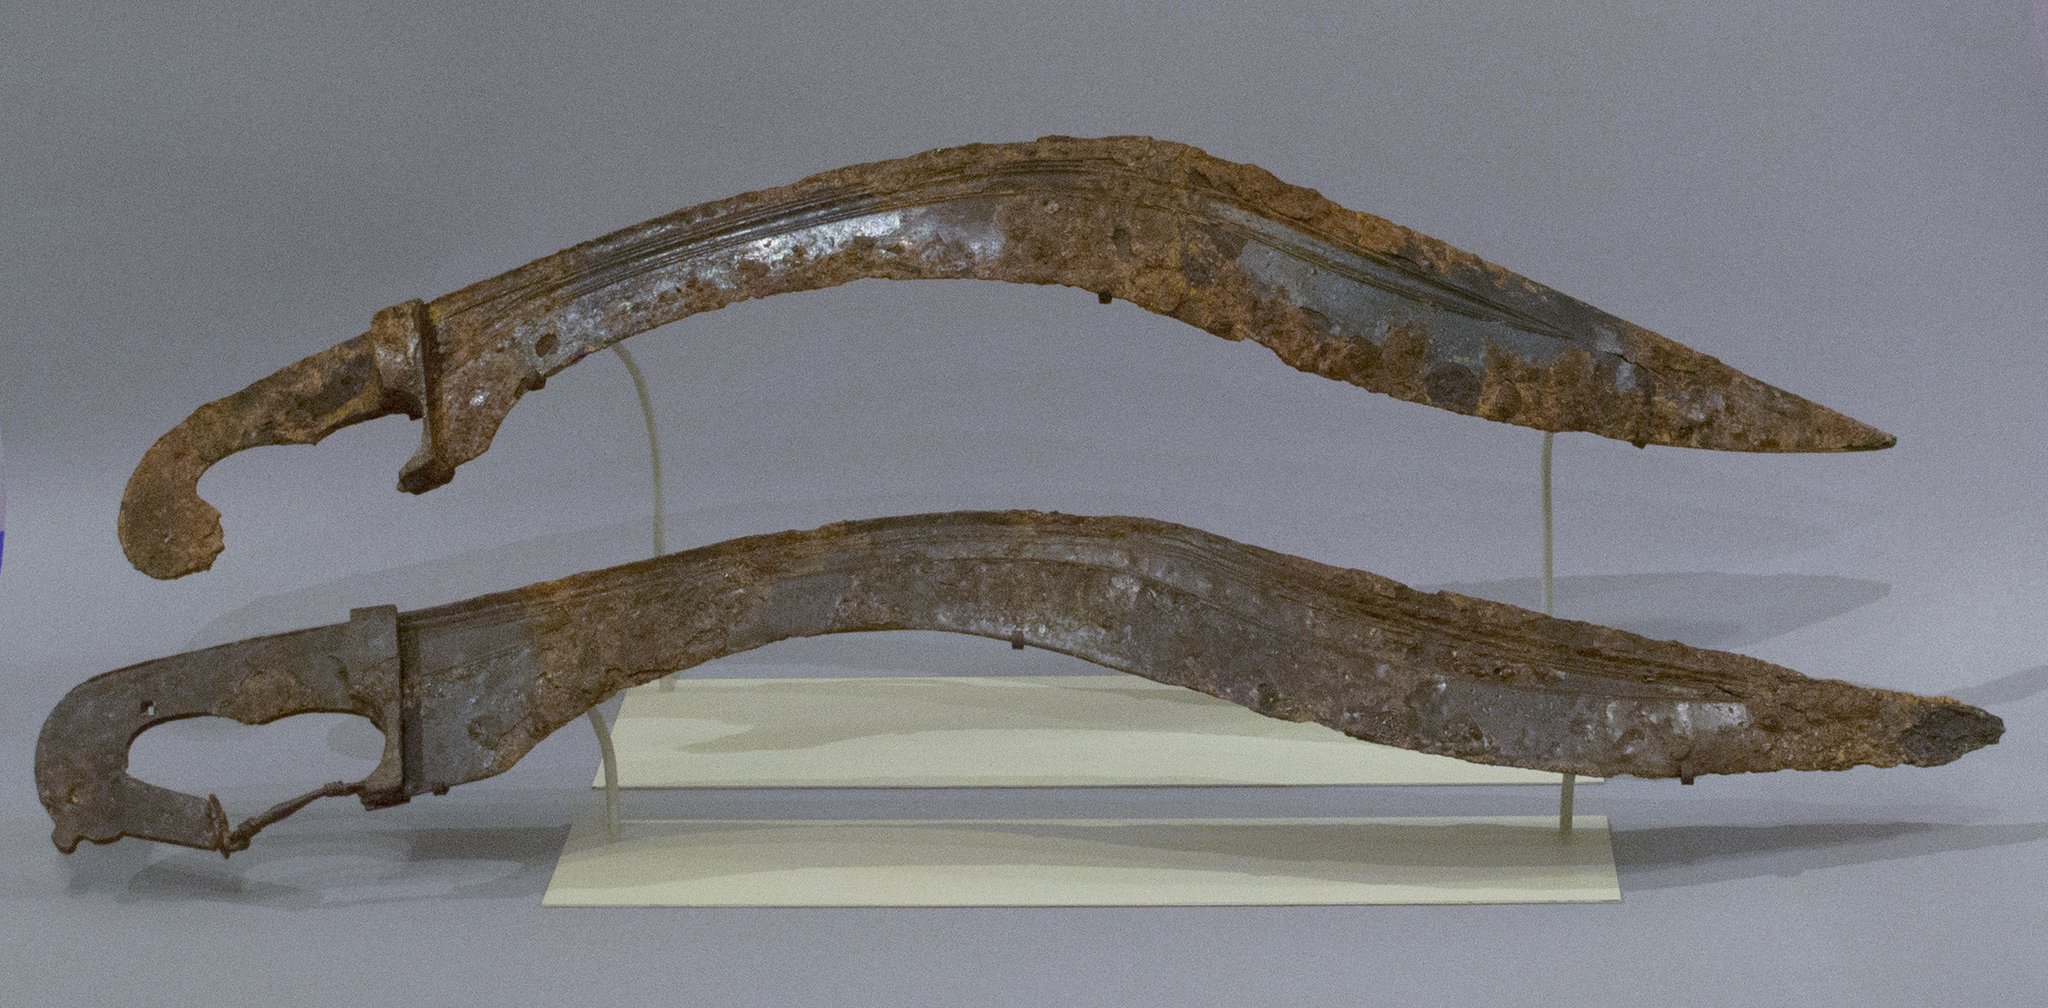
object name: sword, machaira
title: Iron machaira (sword)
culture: greek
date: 500-301 BCE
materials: iron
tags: swords